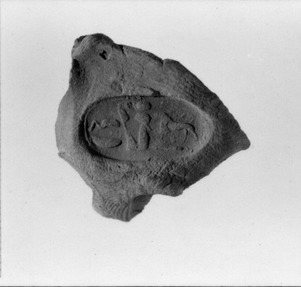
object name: sealing, nebmaatre, amenhotep iii, horus, re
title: Document Sealing With Multiple Seal Impressions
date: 1390-1352 BCE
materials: mud